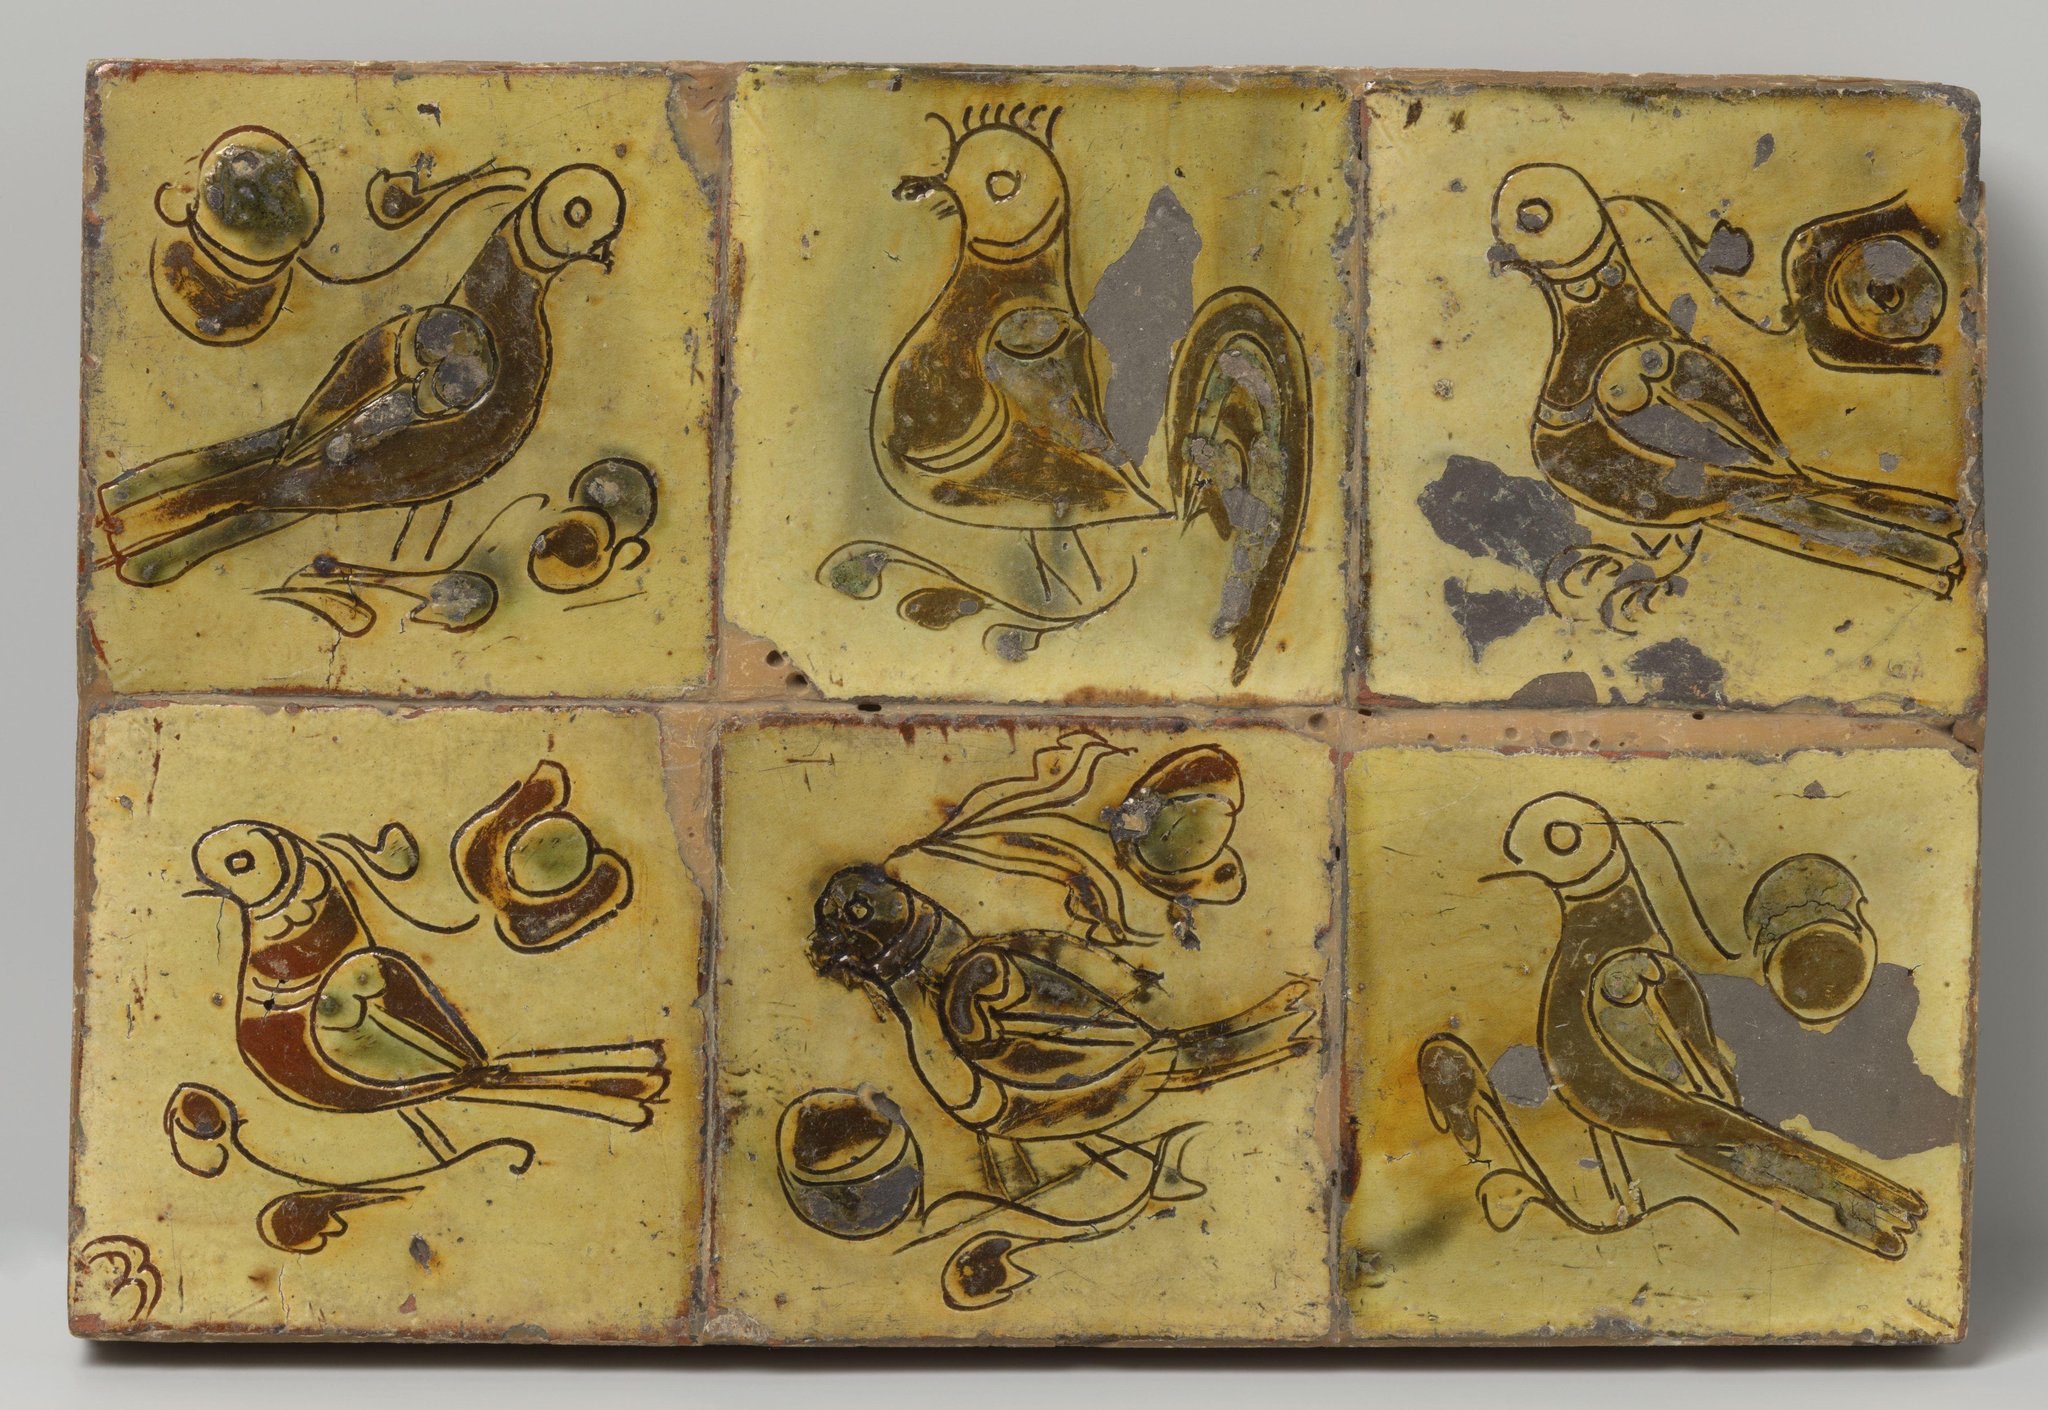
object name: haardtegel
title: Veld van zes tegels met vogels op takken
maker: Anonymous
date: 1700-1800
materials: earthenware, glaze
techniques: scoring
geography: limburg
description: Veld van zes tegels (2 x 3) elk met een vogel op een tak.